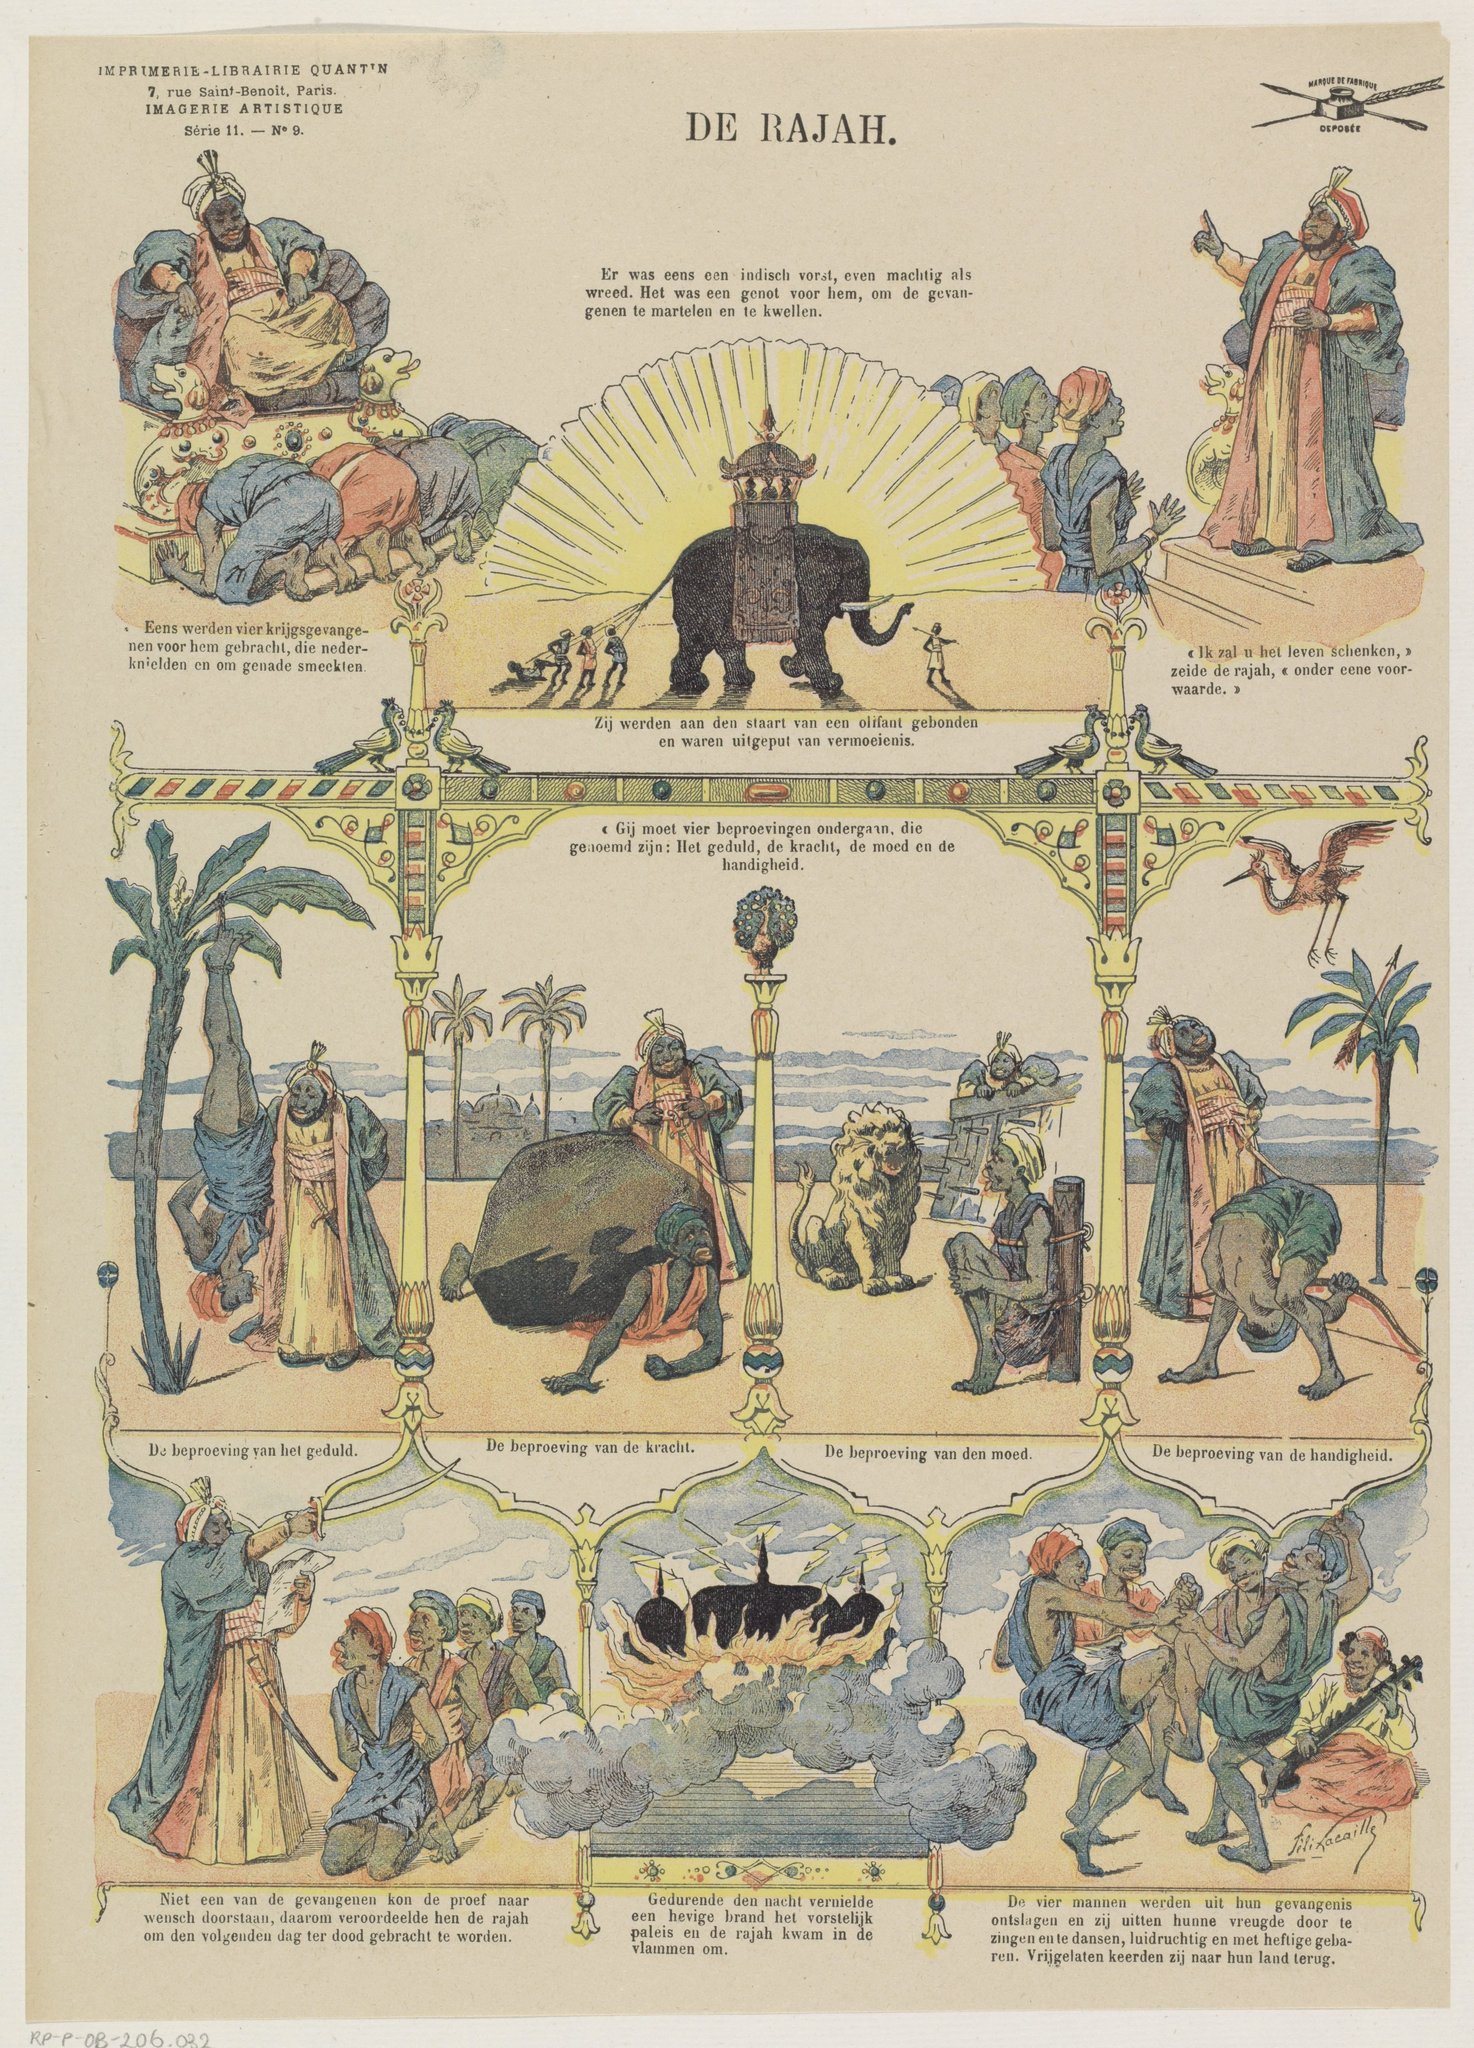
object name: popular print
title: De Rajah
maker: albert quantin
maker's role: printer, publisher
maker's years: 1850-1933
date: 1876-1890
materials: paper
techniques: lithograph, letterpress printing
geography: paris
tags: prisoner; in fetters, tales and fairy tales, ruler, sovereign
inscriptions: : ‘marque de fabrique / deposée’, collector's mark: Lugt 2760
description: Blad met drie rijen met voorstellingen over een Indiase vorst (raja) die zijn gevangenen verschillende beproevingen laat doen. Onder elke afbeelding een onderschrift. Genummerd linksboven: Série 11. - No. 9.